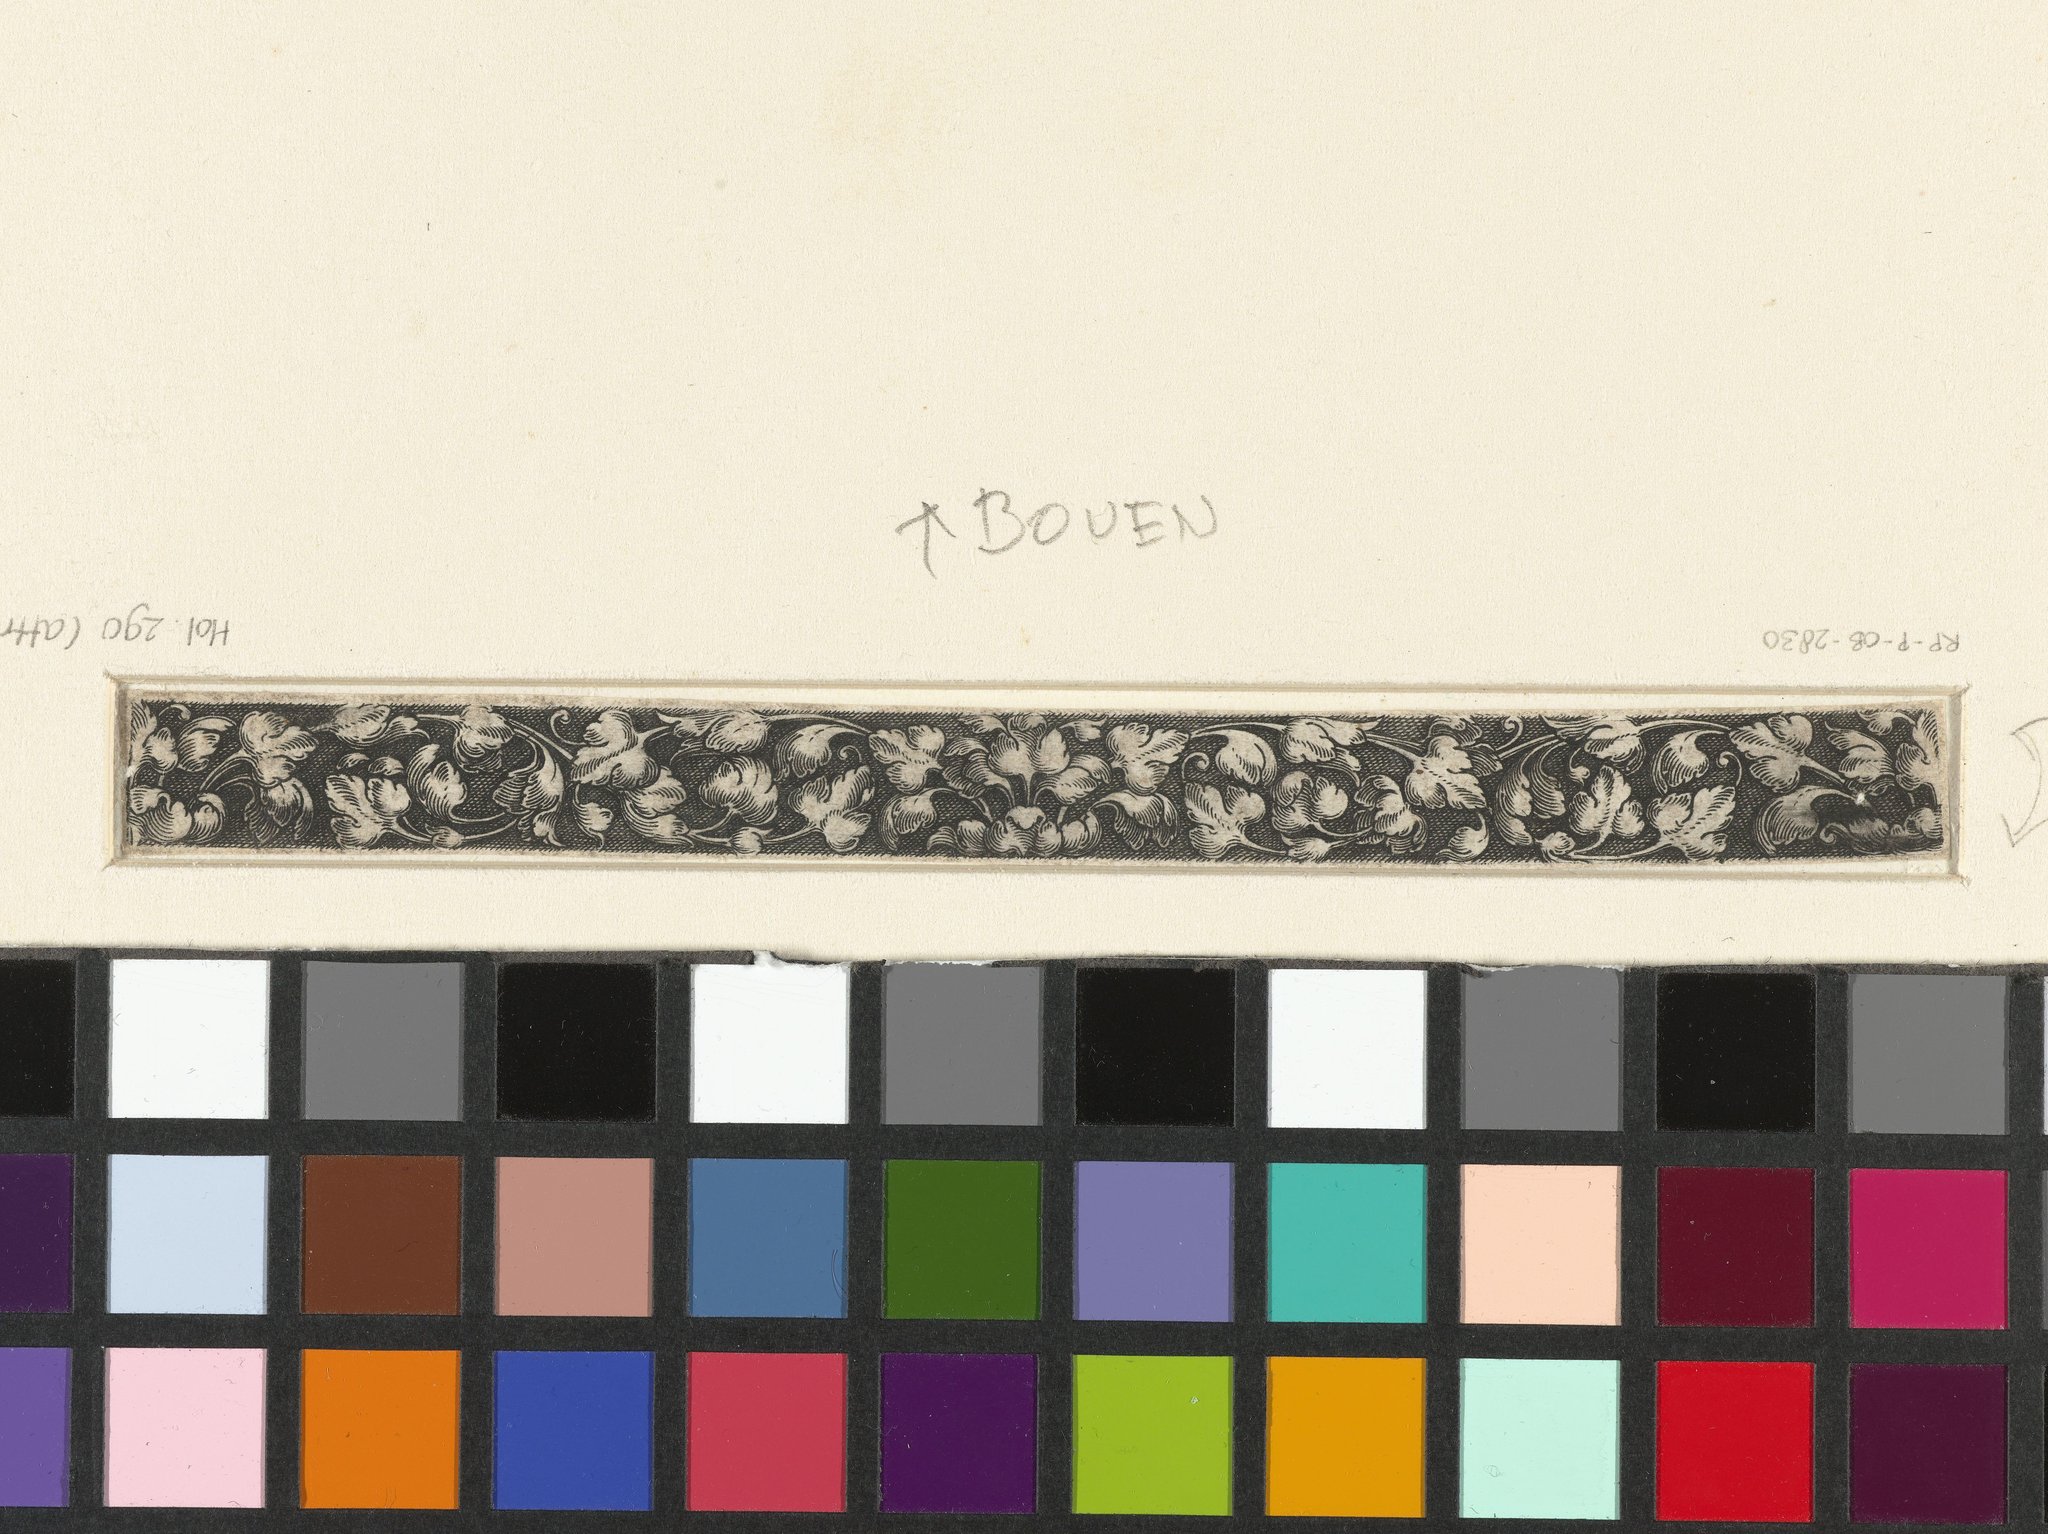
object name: ornament print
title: Fries met bladranken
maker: heinrich aldegrever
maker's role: draughtsman, print maker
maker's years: 1502-1561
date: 1512-1560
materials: paper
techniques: engraving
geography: germany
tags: ornament derived from plant forms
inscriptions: number: ‘21.2. W. 15’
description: Fries met bladranken die zich vanuit het midden en vanaf de zijkanten symmetrisch over het vlak verspreiden.